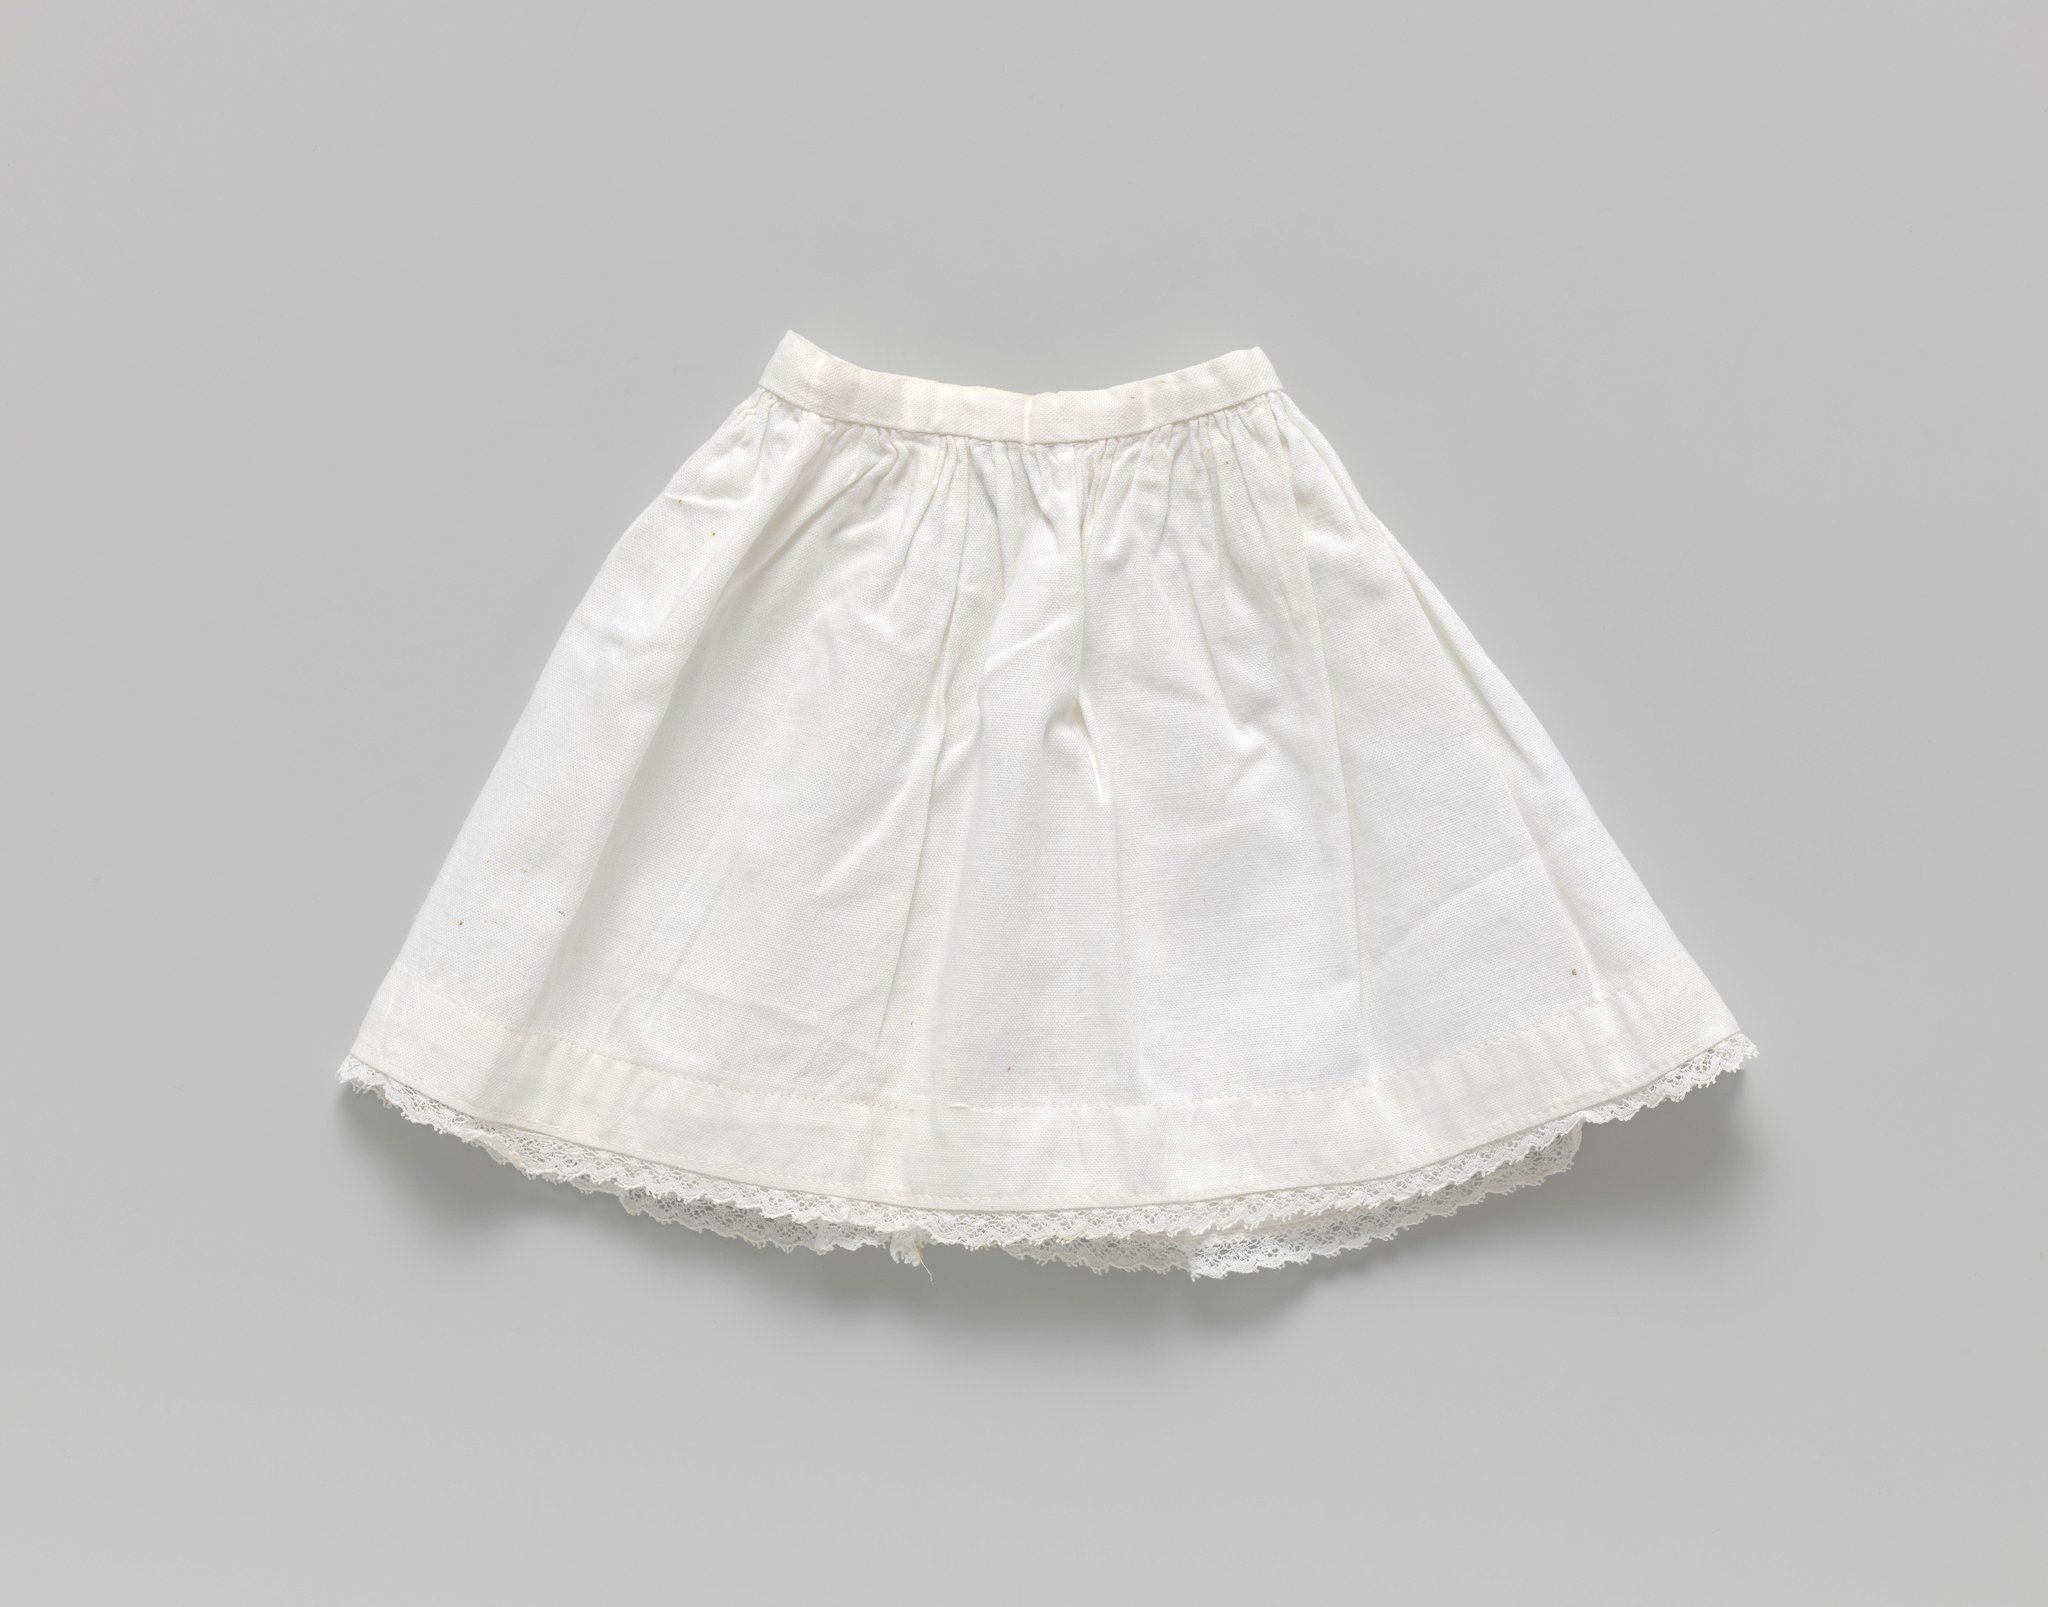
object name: underwear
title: Onderrok van katoen met kant en banden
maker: Anonymous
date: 1910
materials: cotton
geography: germany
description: Onderrok van katoen met kant en banden. Merk "LILLY".